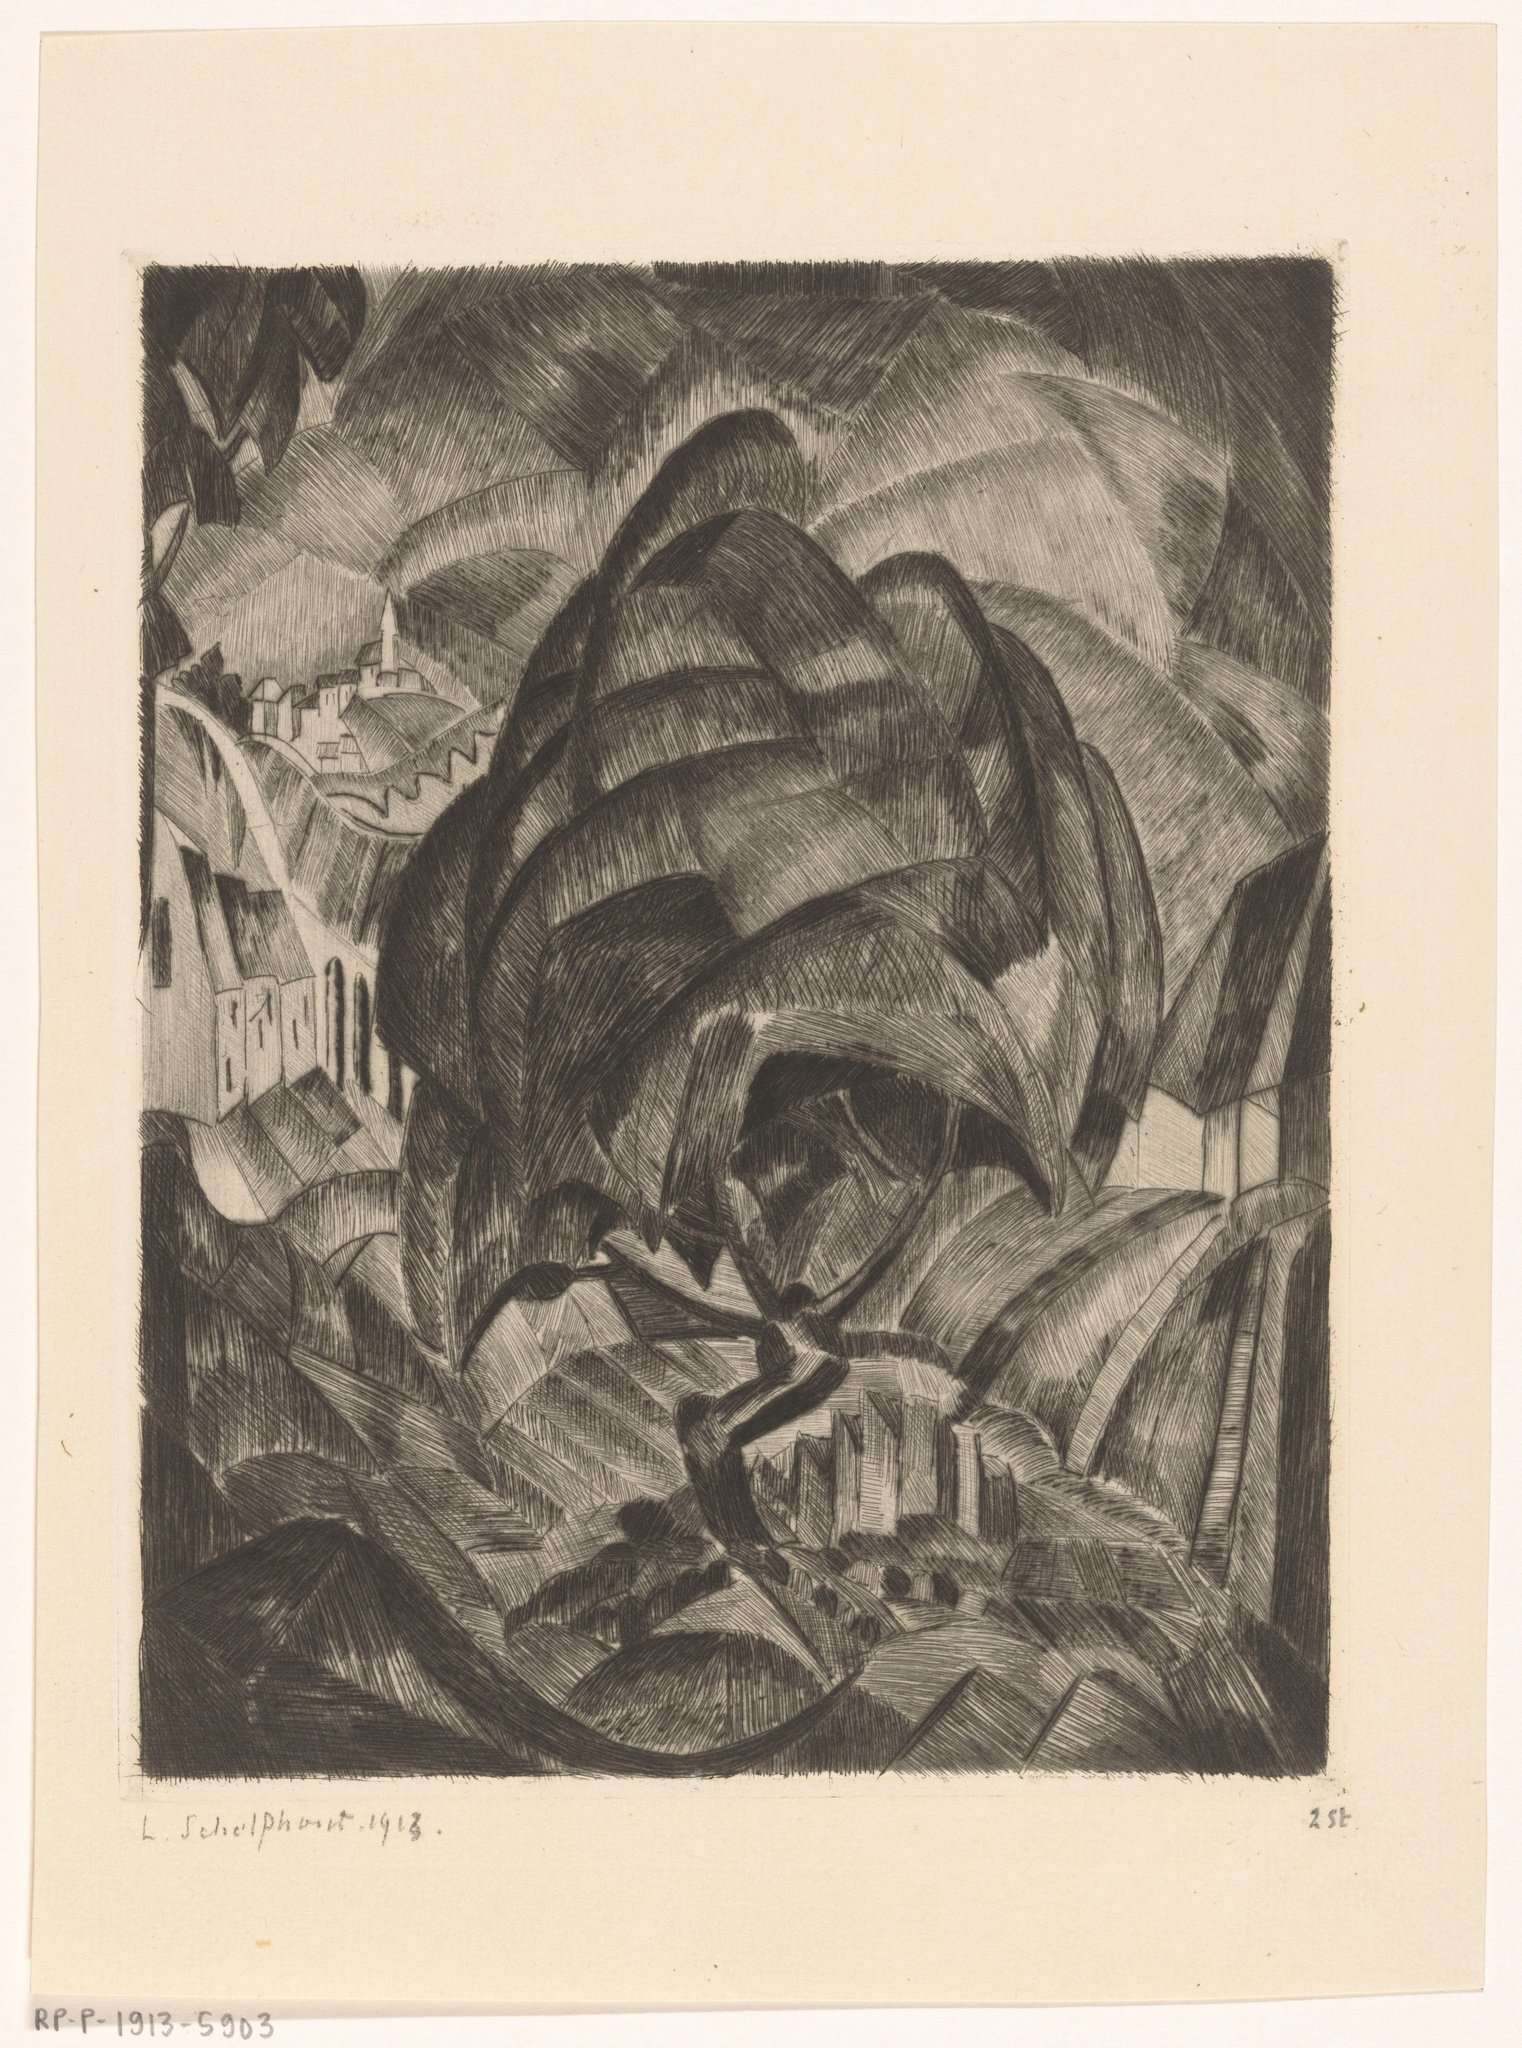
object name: print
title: L'Arbre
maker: lodewijk schelfhout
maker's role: draughtsman, print maker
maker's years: 1881-1943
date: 1913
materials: paper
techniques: drypoint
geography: paris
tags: prospect of village, silhouette of village, low hill country, trees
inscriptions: collector's mark: Lugt 2233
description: Links op de achtergrond een nederzetting met kerk.